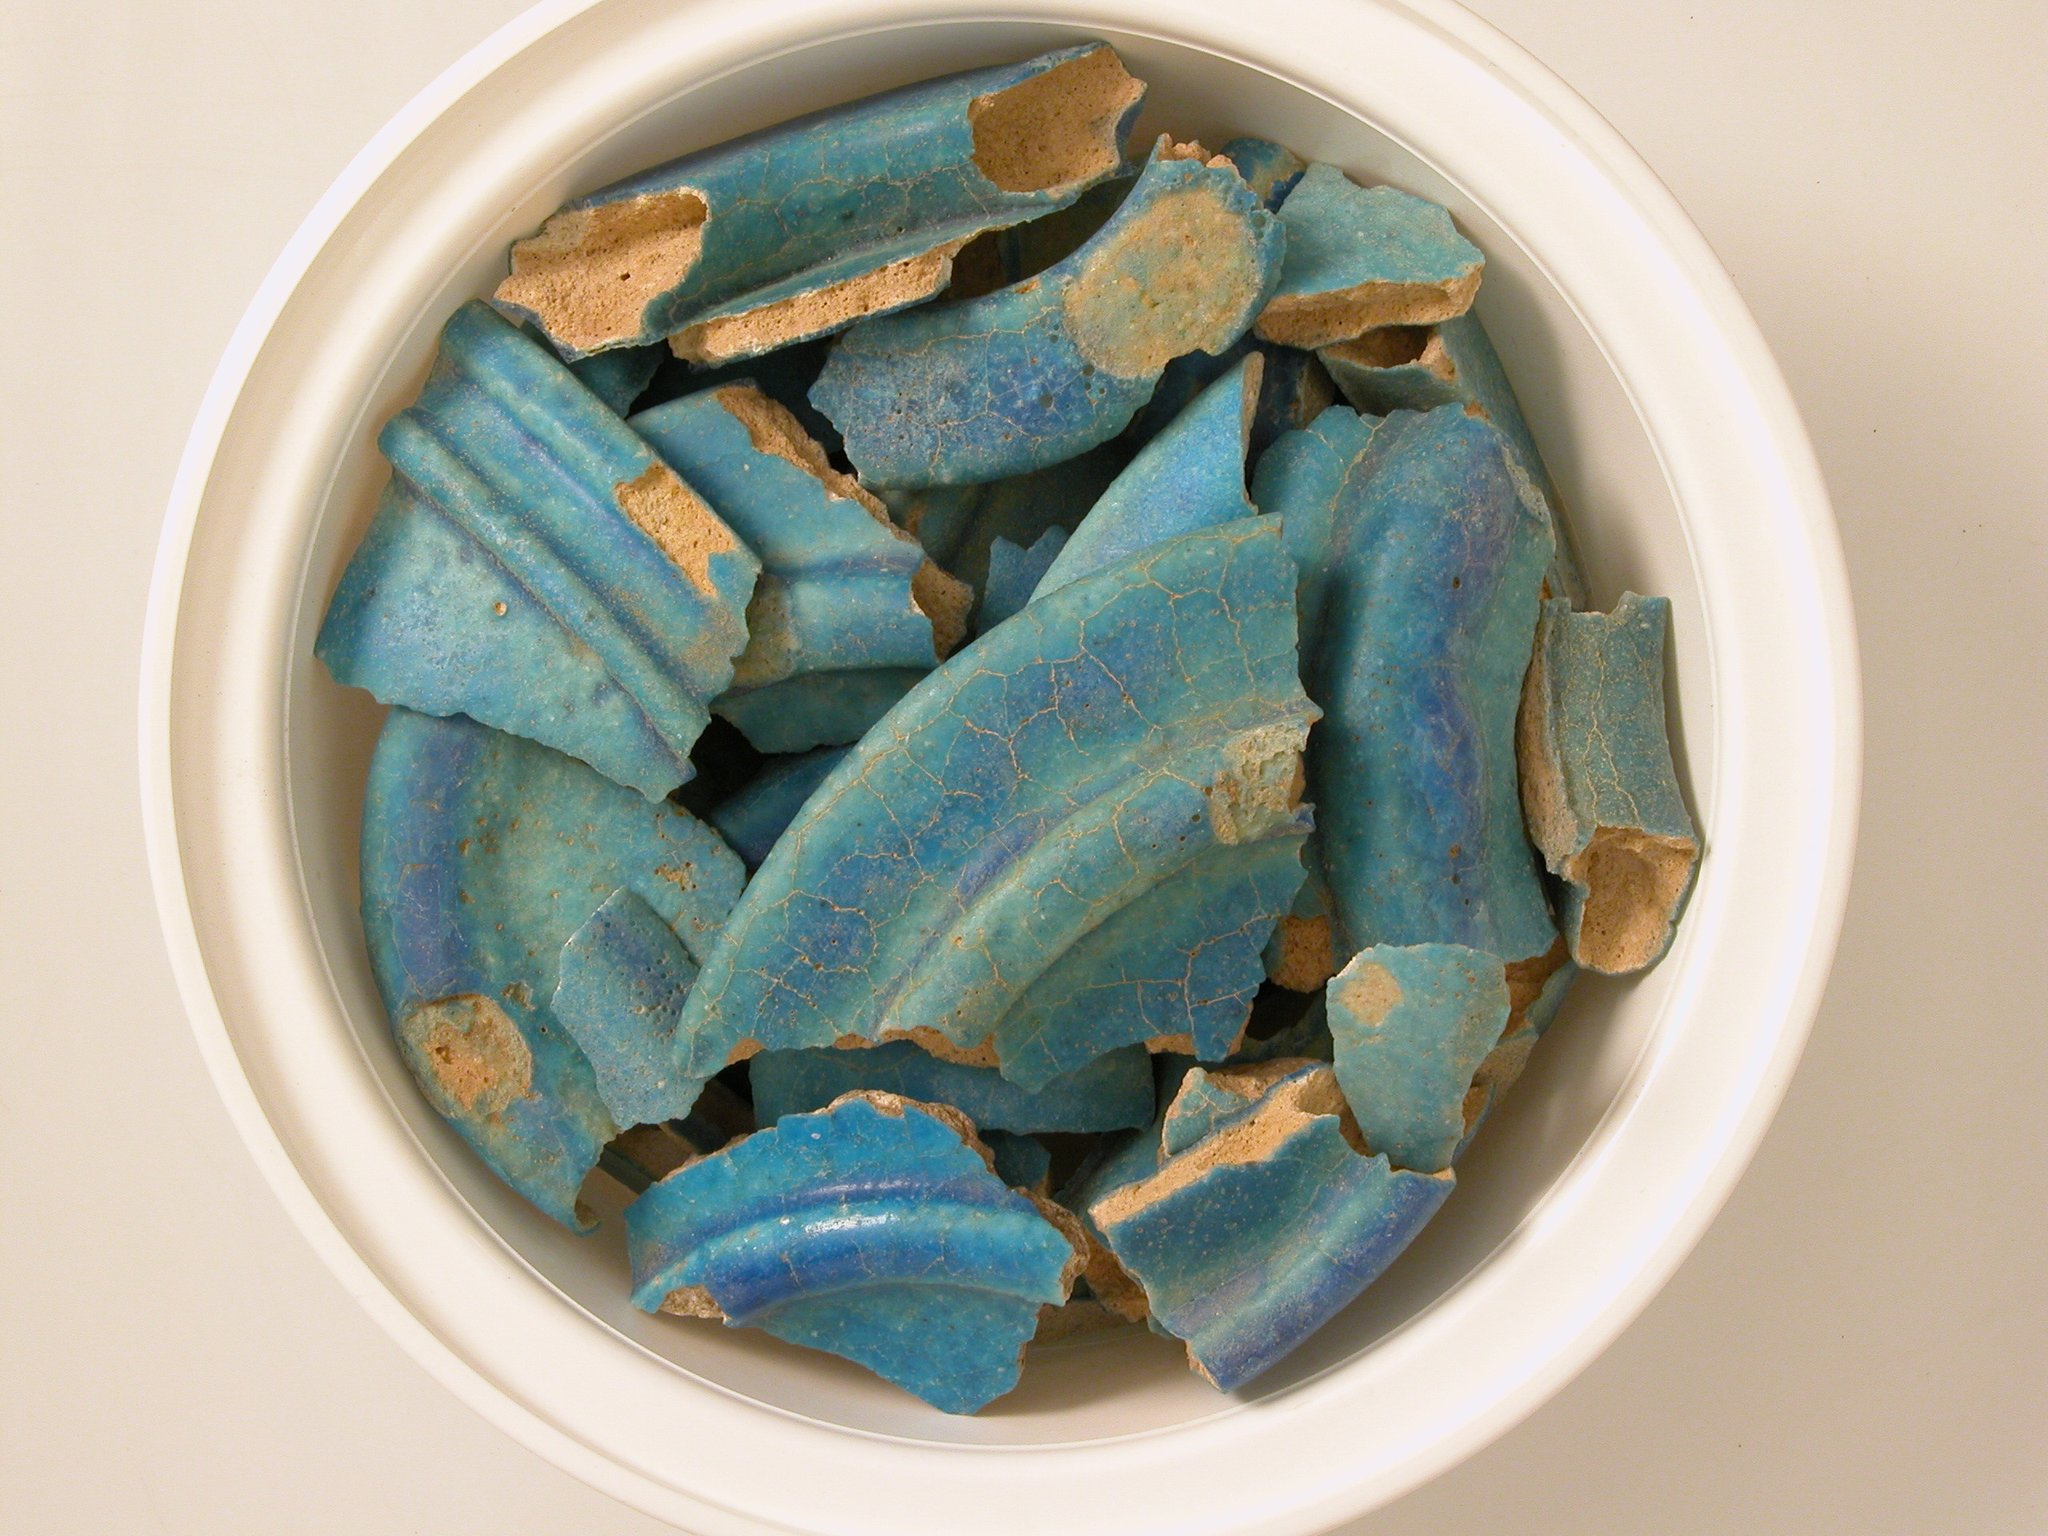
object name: fragment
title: Vessel Fragments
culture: coptic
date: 301-700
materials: earthenware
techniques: glazing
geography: egypt